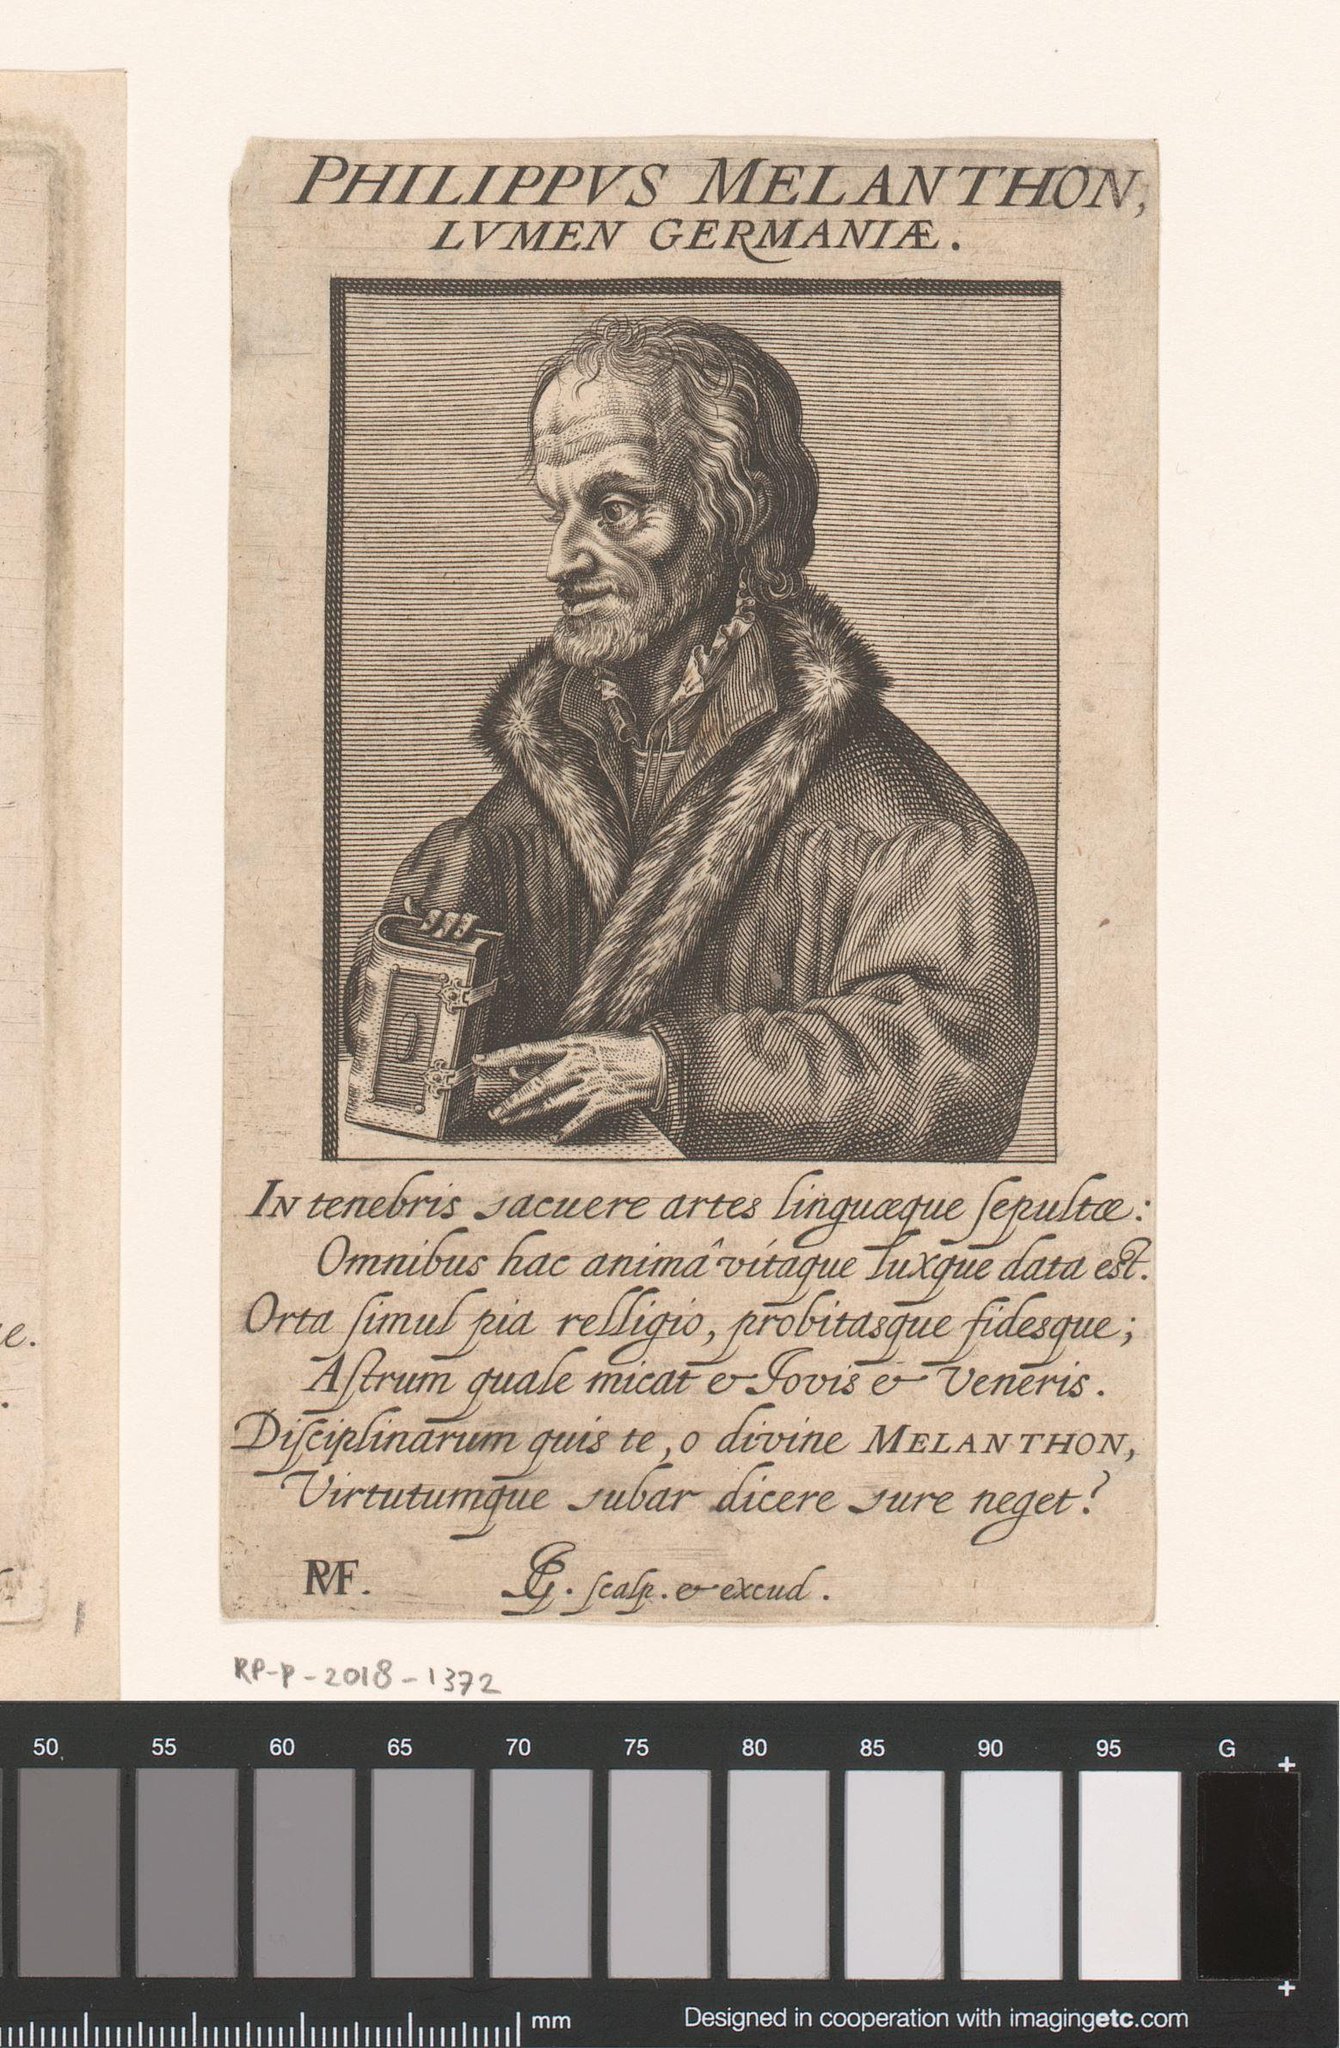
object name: print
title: Portret van Philipp Melanchthon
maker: jacques granthomme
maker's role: print maker, publisher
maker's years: 1550-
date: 1588-1622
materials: paper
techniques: engraving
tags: historical persons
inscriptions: collector's mark: Lugt 2233